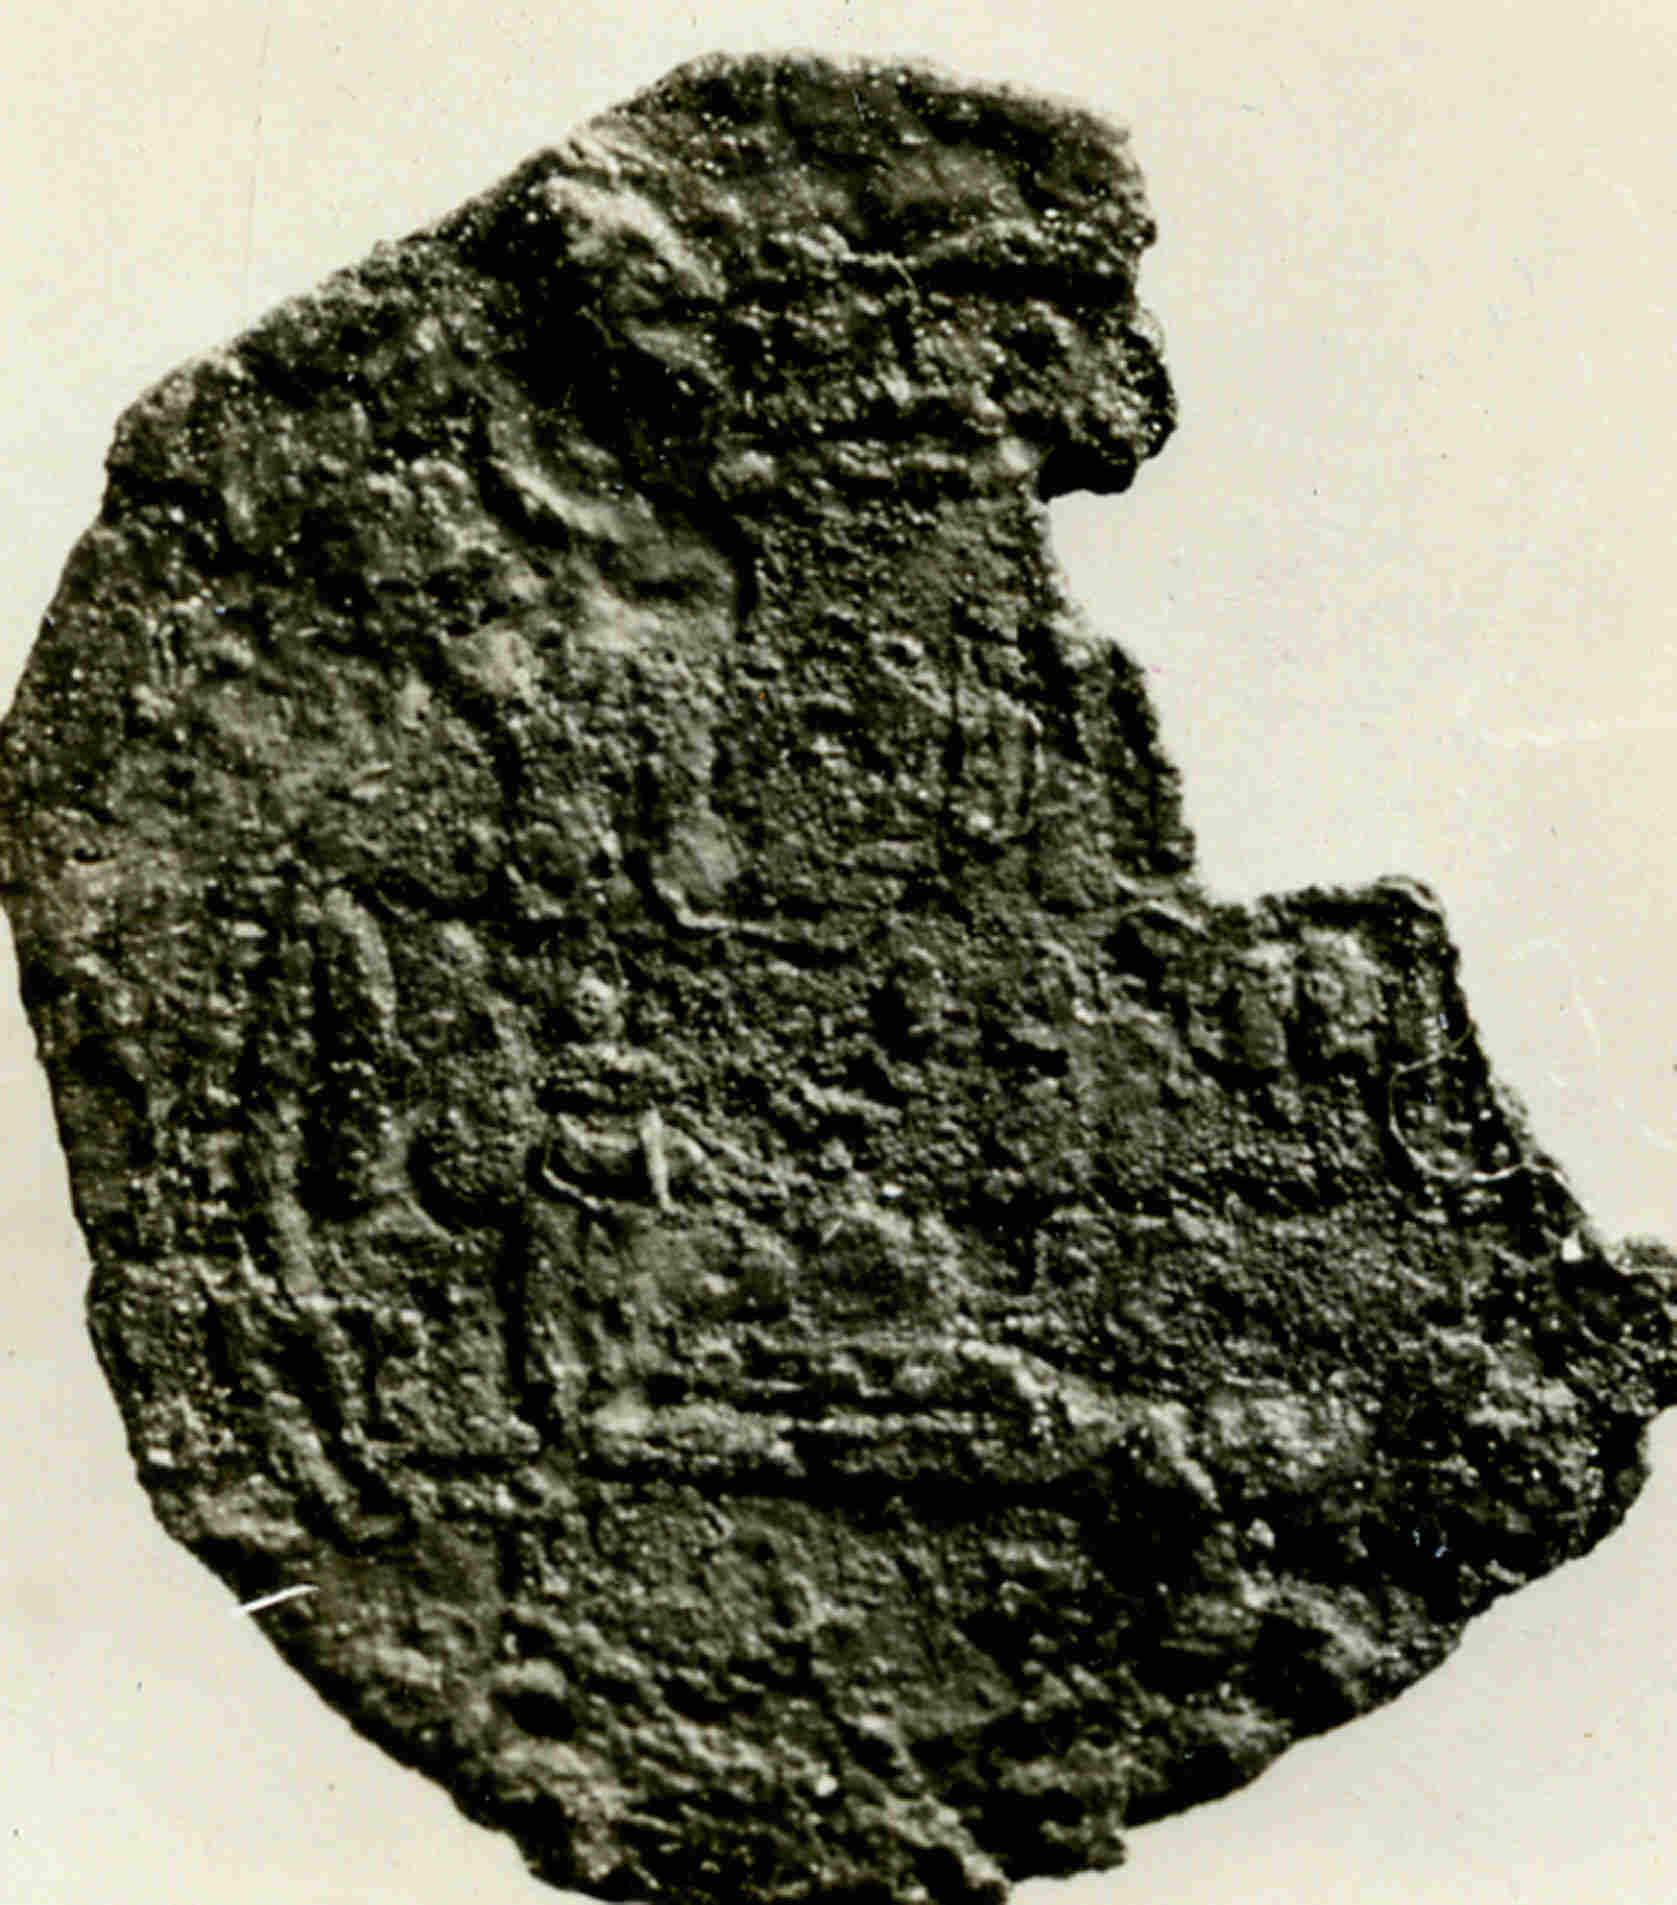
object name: coin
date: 701-900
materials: copper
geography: iran